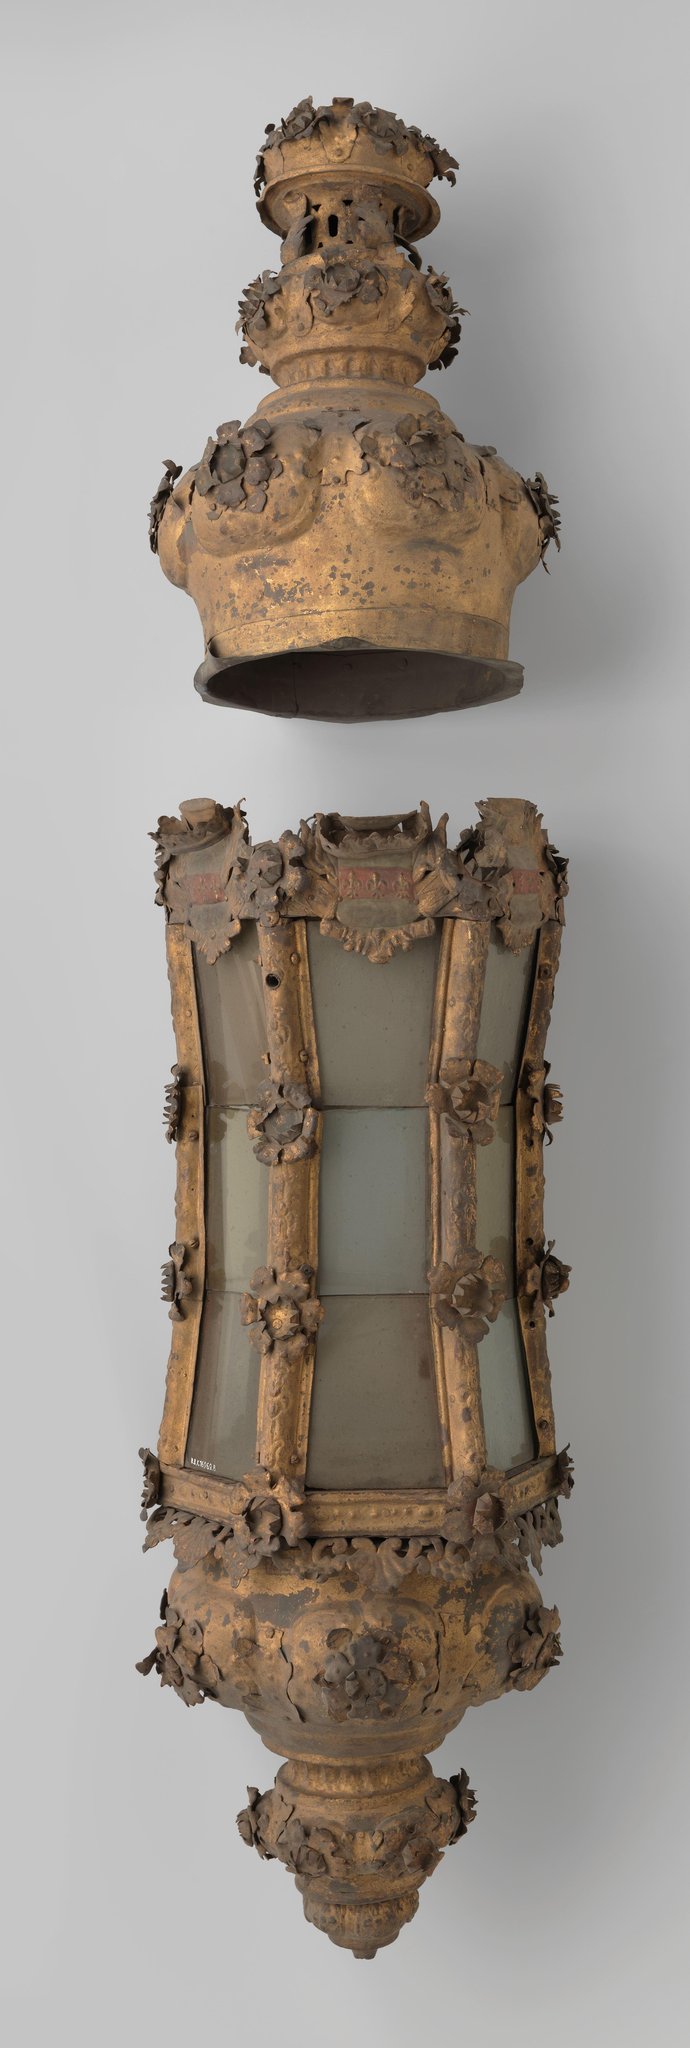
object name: lantern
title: Boven- en middendeel van lantaarn met wapens boven de ruiten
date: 1700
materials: glass, iron, wood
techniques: gilding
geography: venice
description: Zeszijdig middendeel, gevormd uit iets naar binnen gebogen stijlen, een koepelvormig dak bestaande uit verschillende geledingen. Boven de vensters zijn wapens aangebracht. De lamp wordt versierd met rozetten. Afkomstig uit de verzameling Dr. F. Mannheimer.